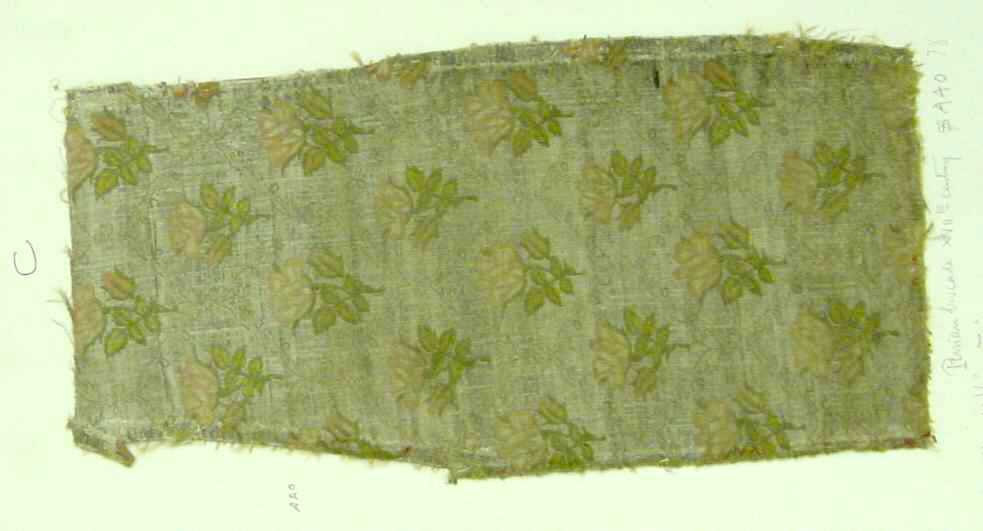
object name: textile fragment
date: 1601-1700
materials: metal thread, silk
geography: iran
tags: flowers